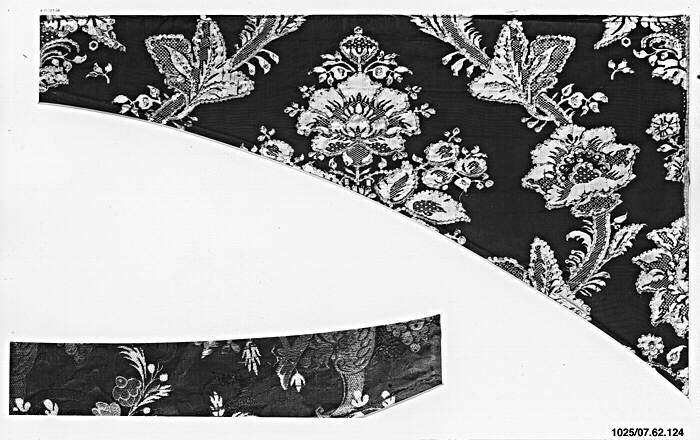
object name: piece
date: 1725-1730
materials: metal, silk